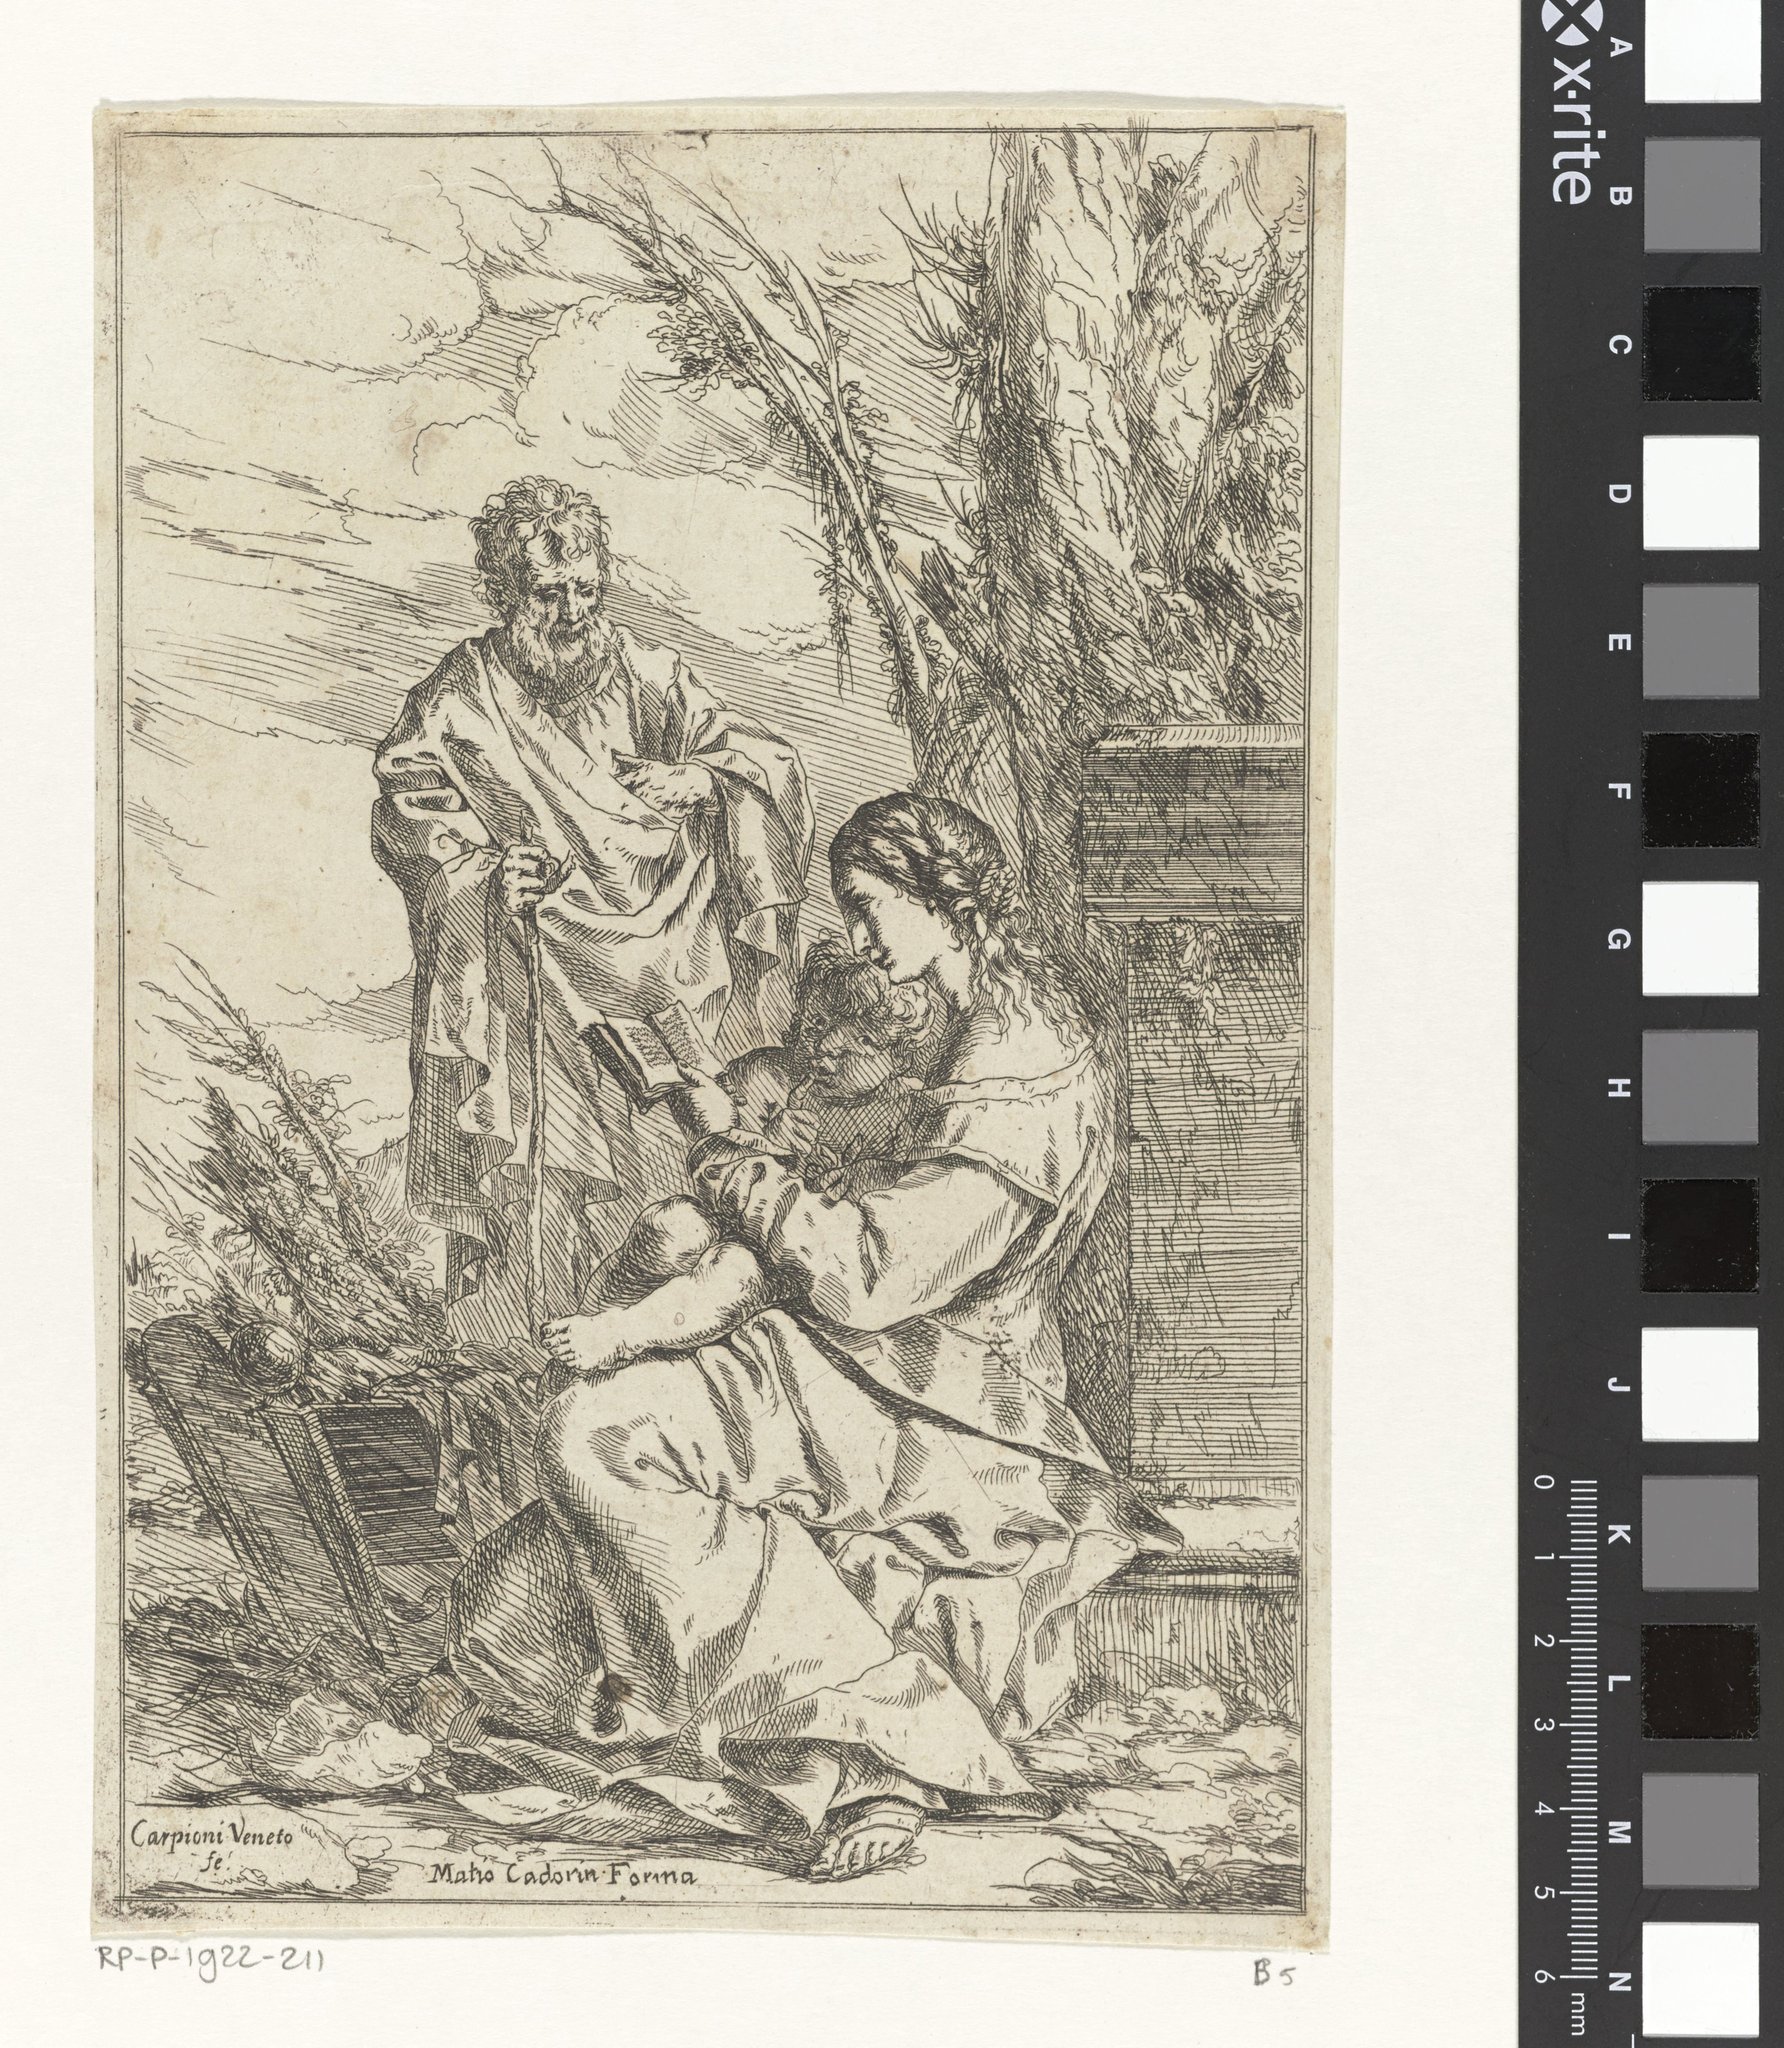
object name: print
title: Rest on the Flight into Egypt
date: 1623-1679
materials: paper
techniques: etching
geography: venice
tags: holy family, and derived representations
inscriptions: collector's mark: Lugt 2233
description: De Heilige Familie in een landschap. Maria leest een boek. Het Christuskind zit op haar schoot en gebaart naar de beschouwer dat deze stil moet zijn.